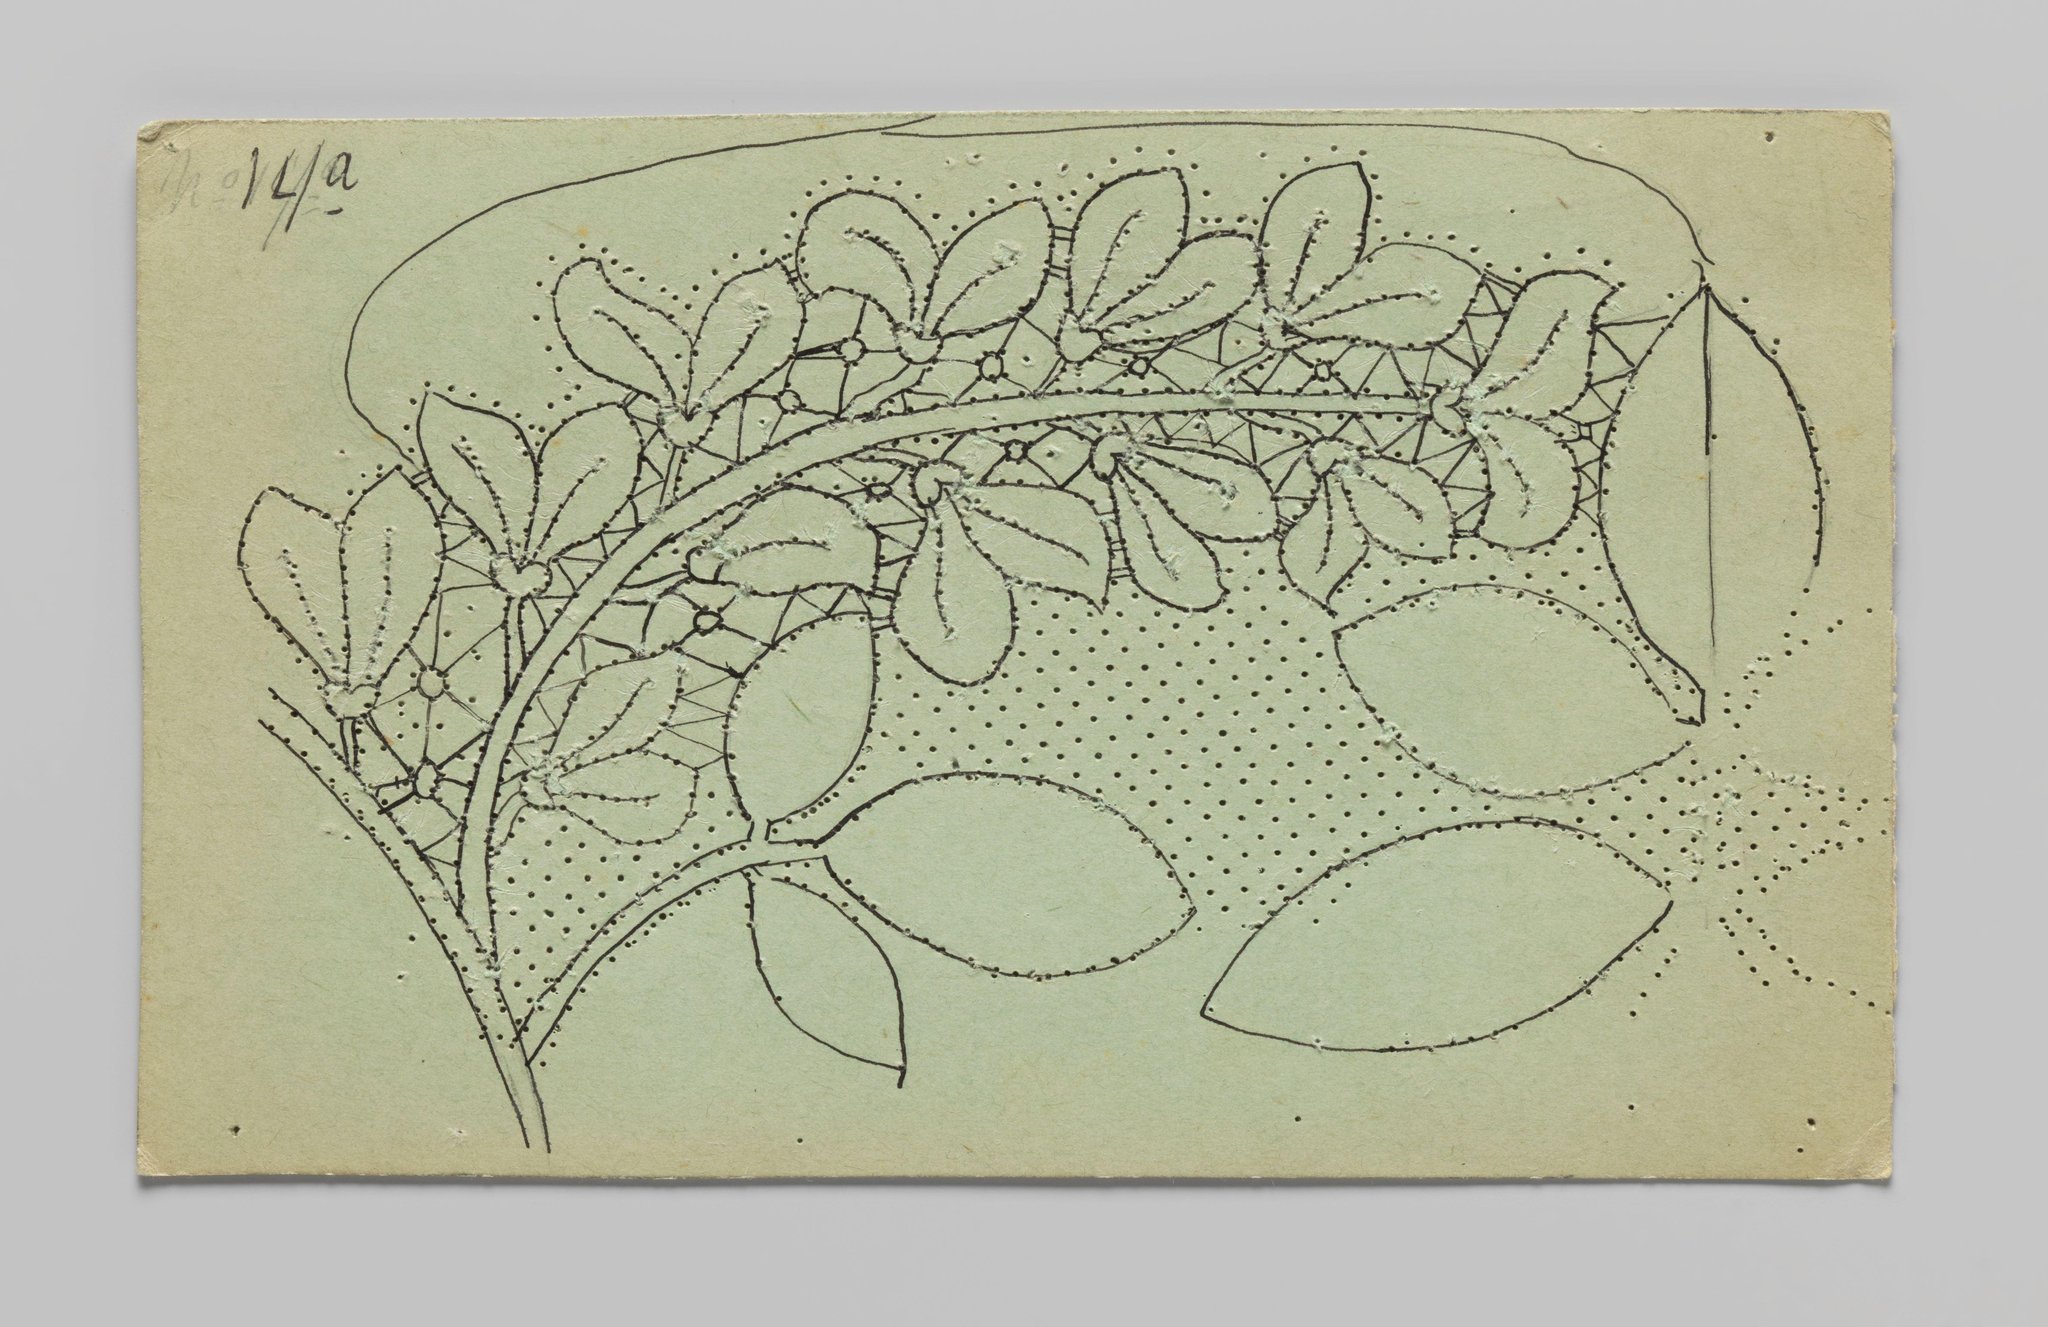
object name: tool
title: Kantpatroon voor een kleed van kloskant met goudenregentakken en -bloemen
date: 1912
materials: paper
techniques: drawing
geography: apeldoorn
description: Kantbrief of kantpatroon met een deel van het patroon voor een kleed met invnr. BK-1979-84. De brief is genummerd (14a).